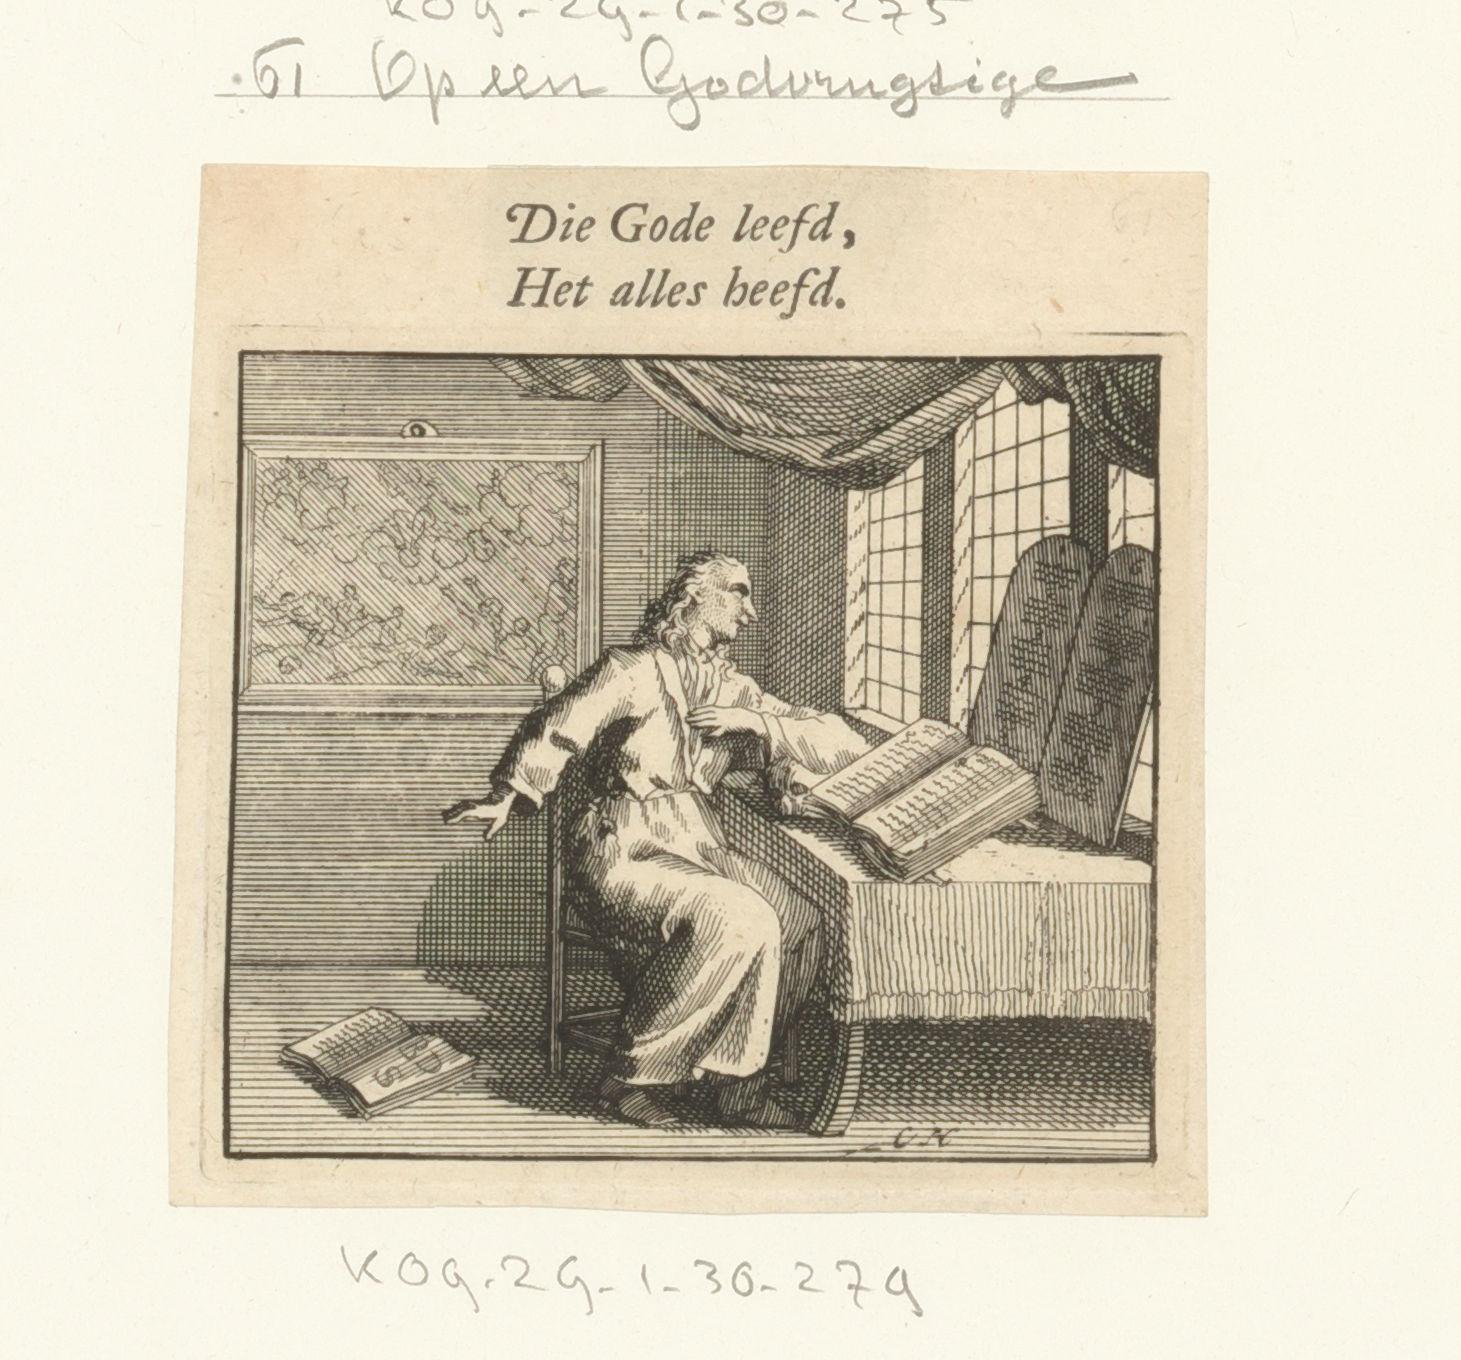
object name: print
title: Die Gode leefd, Het alles heeft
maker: cornelis huyberts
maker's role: print maker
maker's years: 1669-1709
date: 1725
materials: paper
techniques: etching, letterpress printing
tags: christian doctrine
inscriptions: stamp, collector's mark: Lugt 1641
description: Prent uit: Graauwhart, Hendrik. Voorbeeldelyke zeede-lessen, genoomen uyt den eersten toestand des werelds (...). Amsterdam: Johannes Ratelband, 1725. Prent ook gebruikt voor eerdere en (1709) latere uitgave (1756, 1761 en 1764).